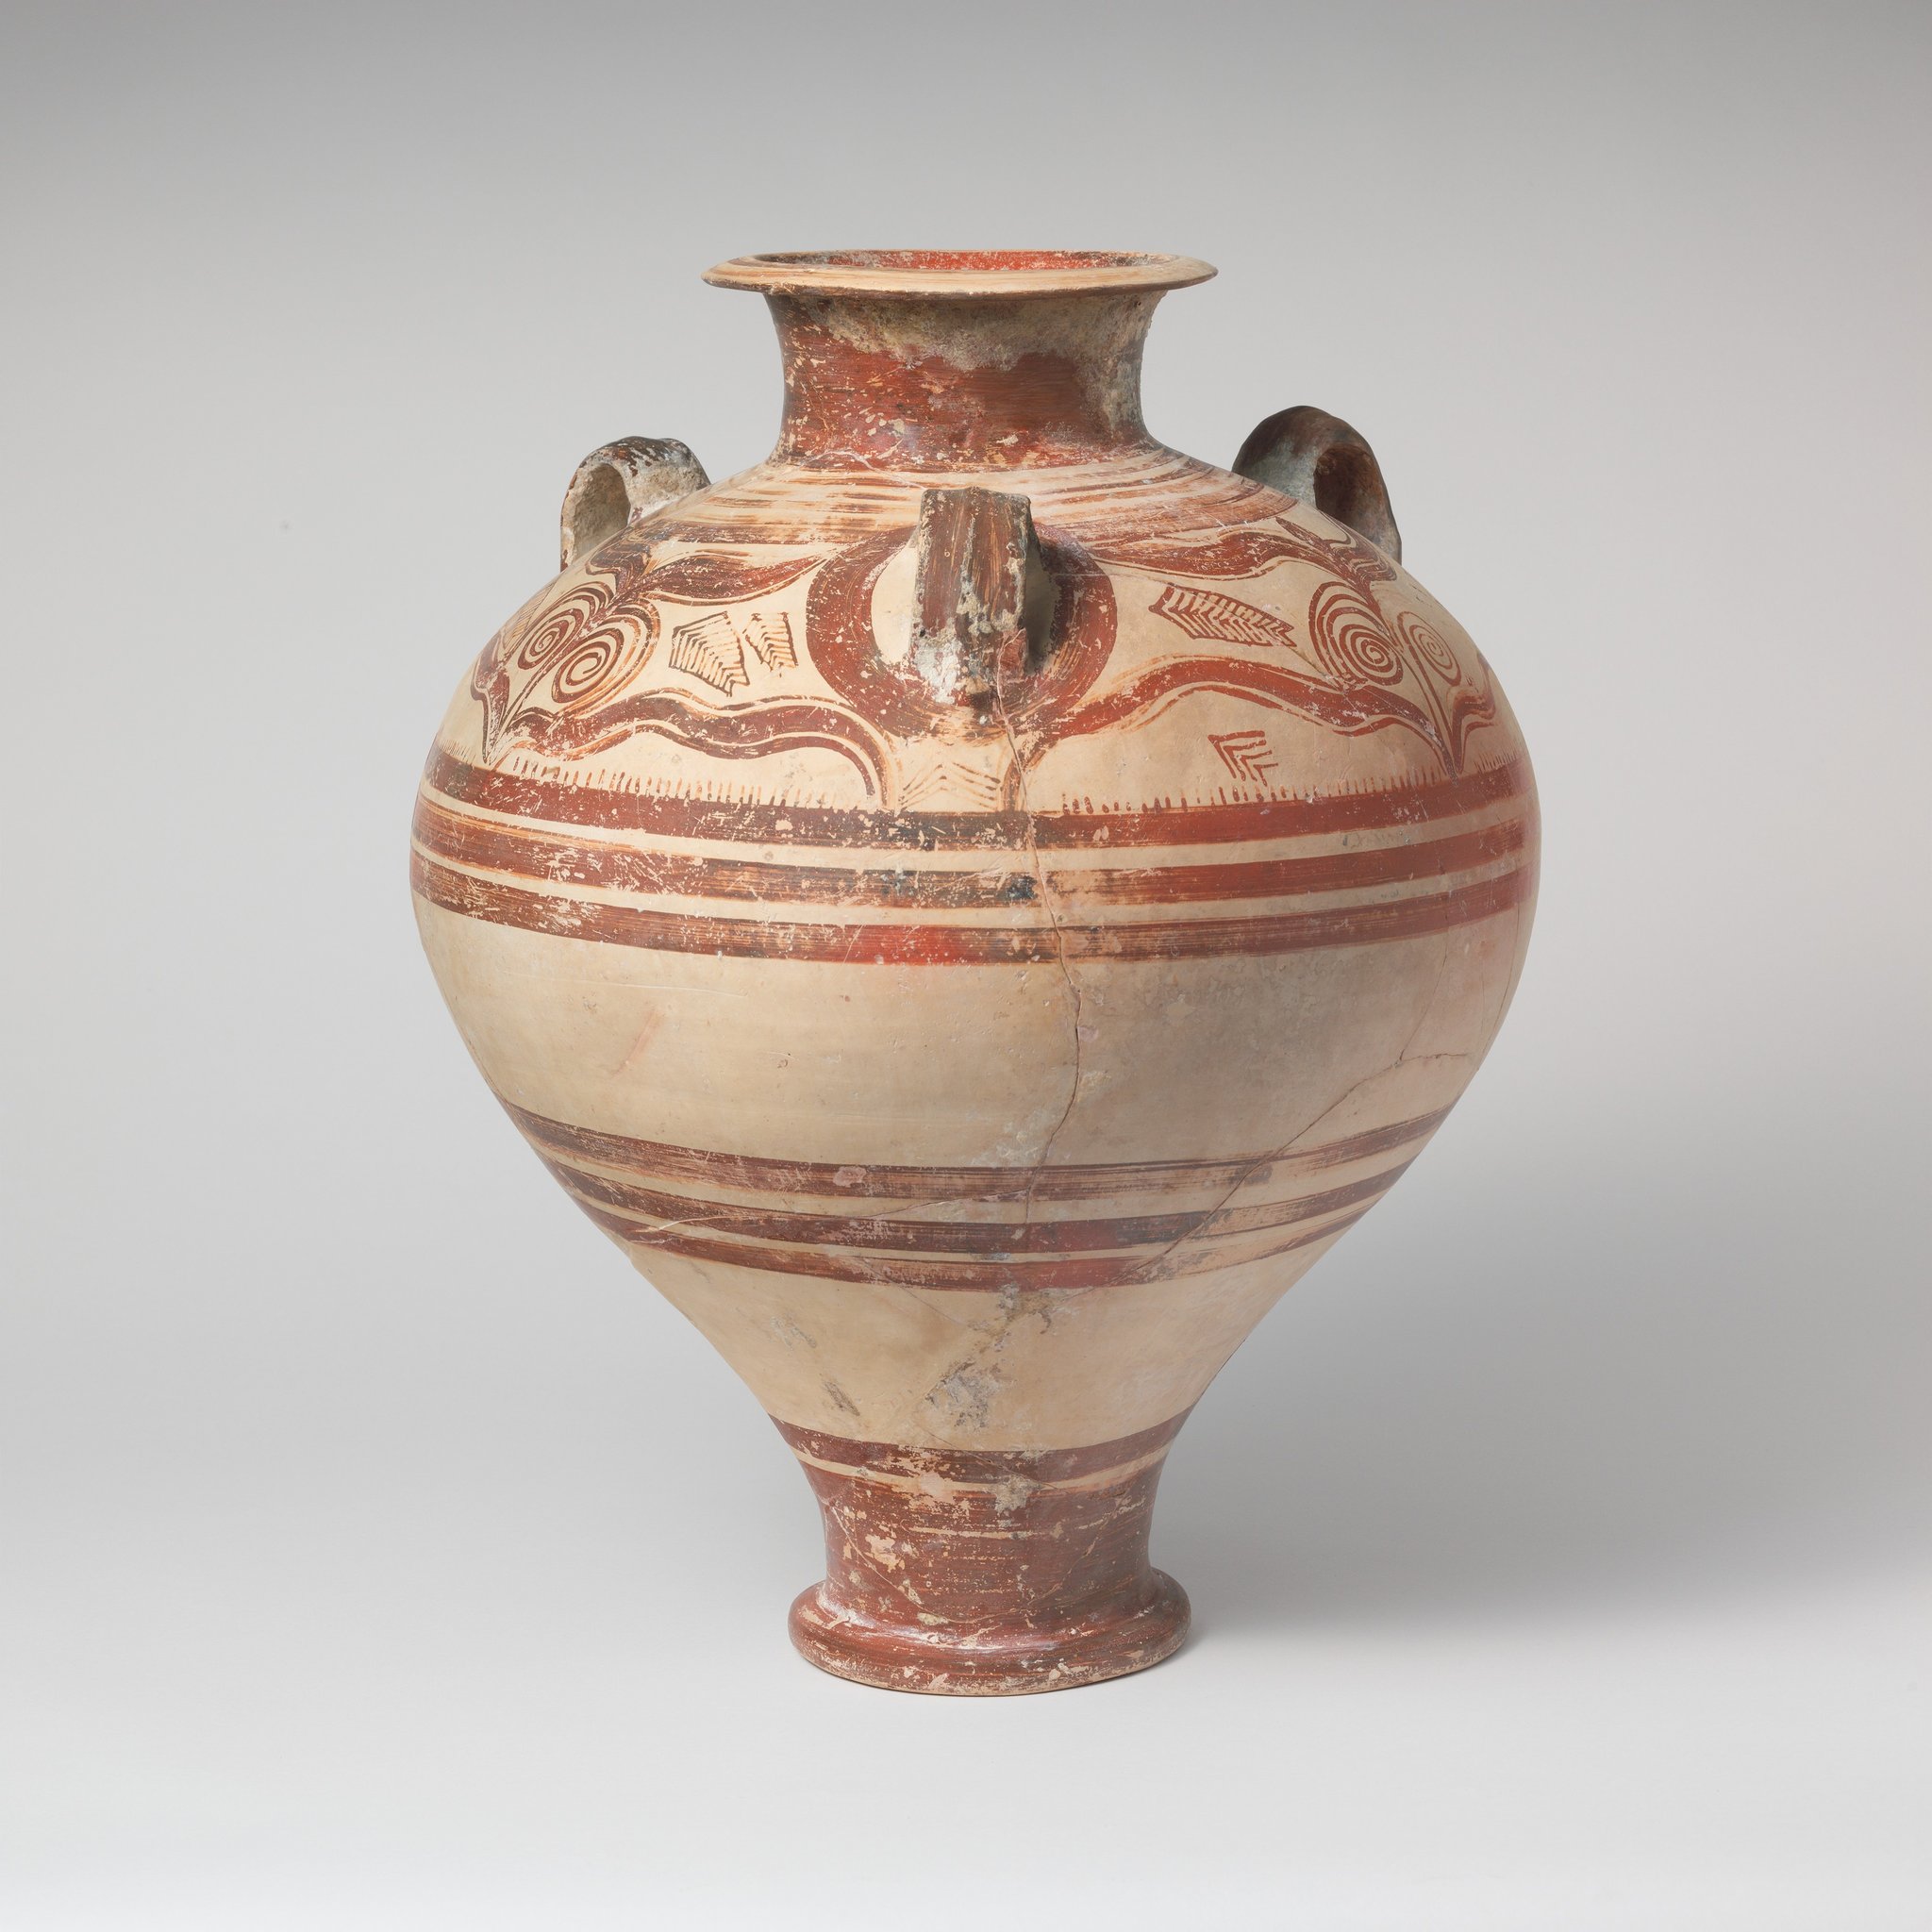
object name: pithoid jar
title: Terracotta pithoid jar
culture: mycenaean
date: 1375-1325 BCE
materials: terracotta